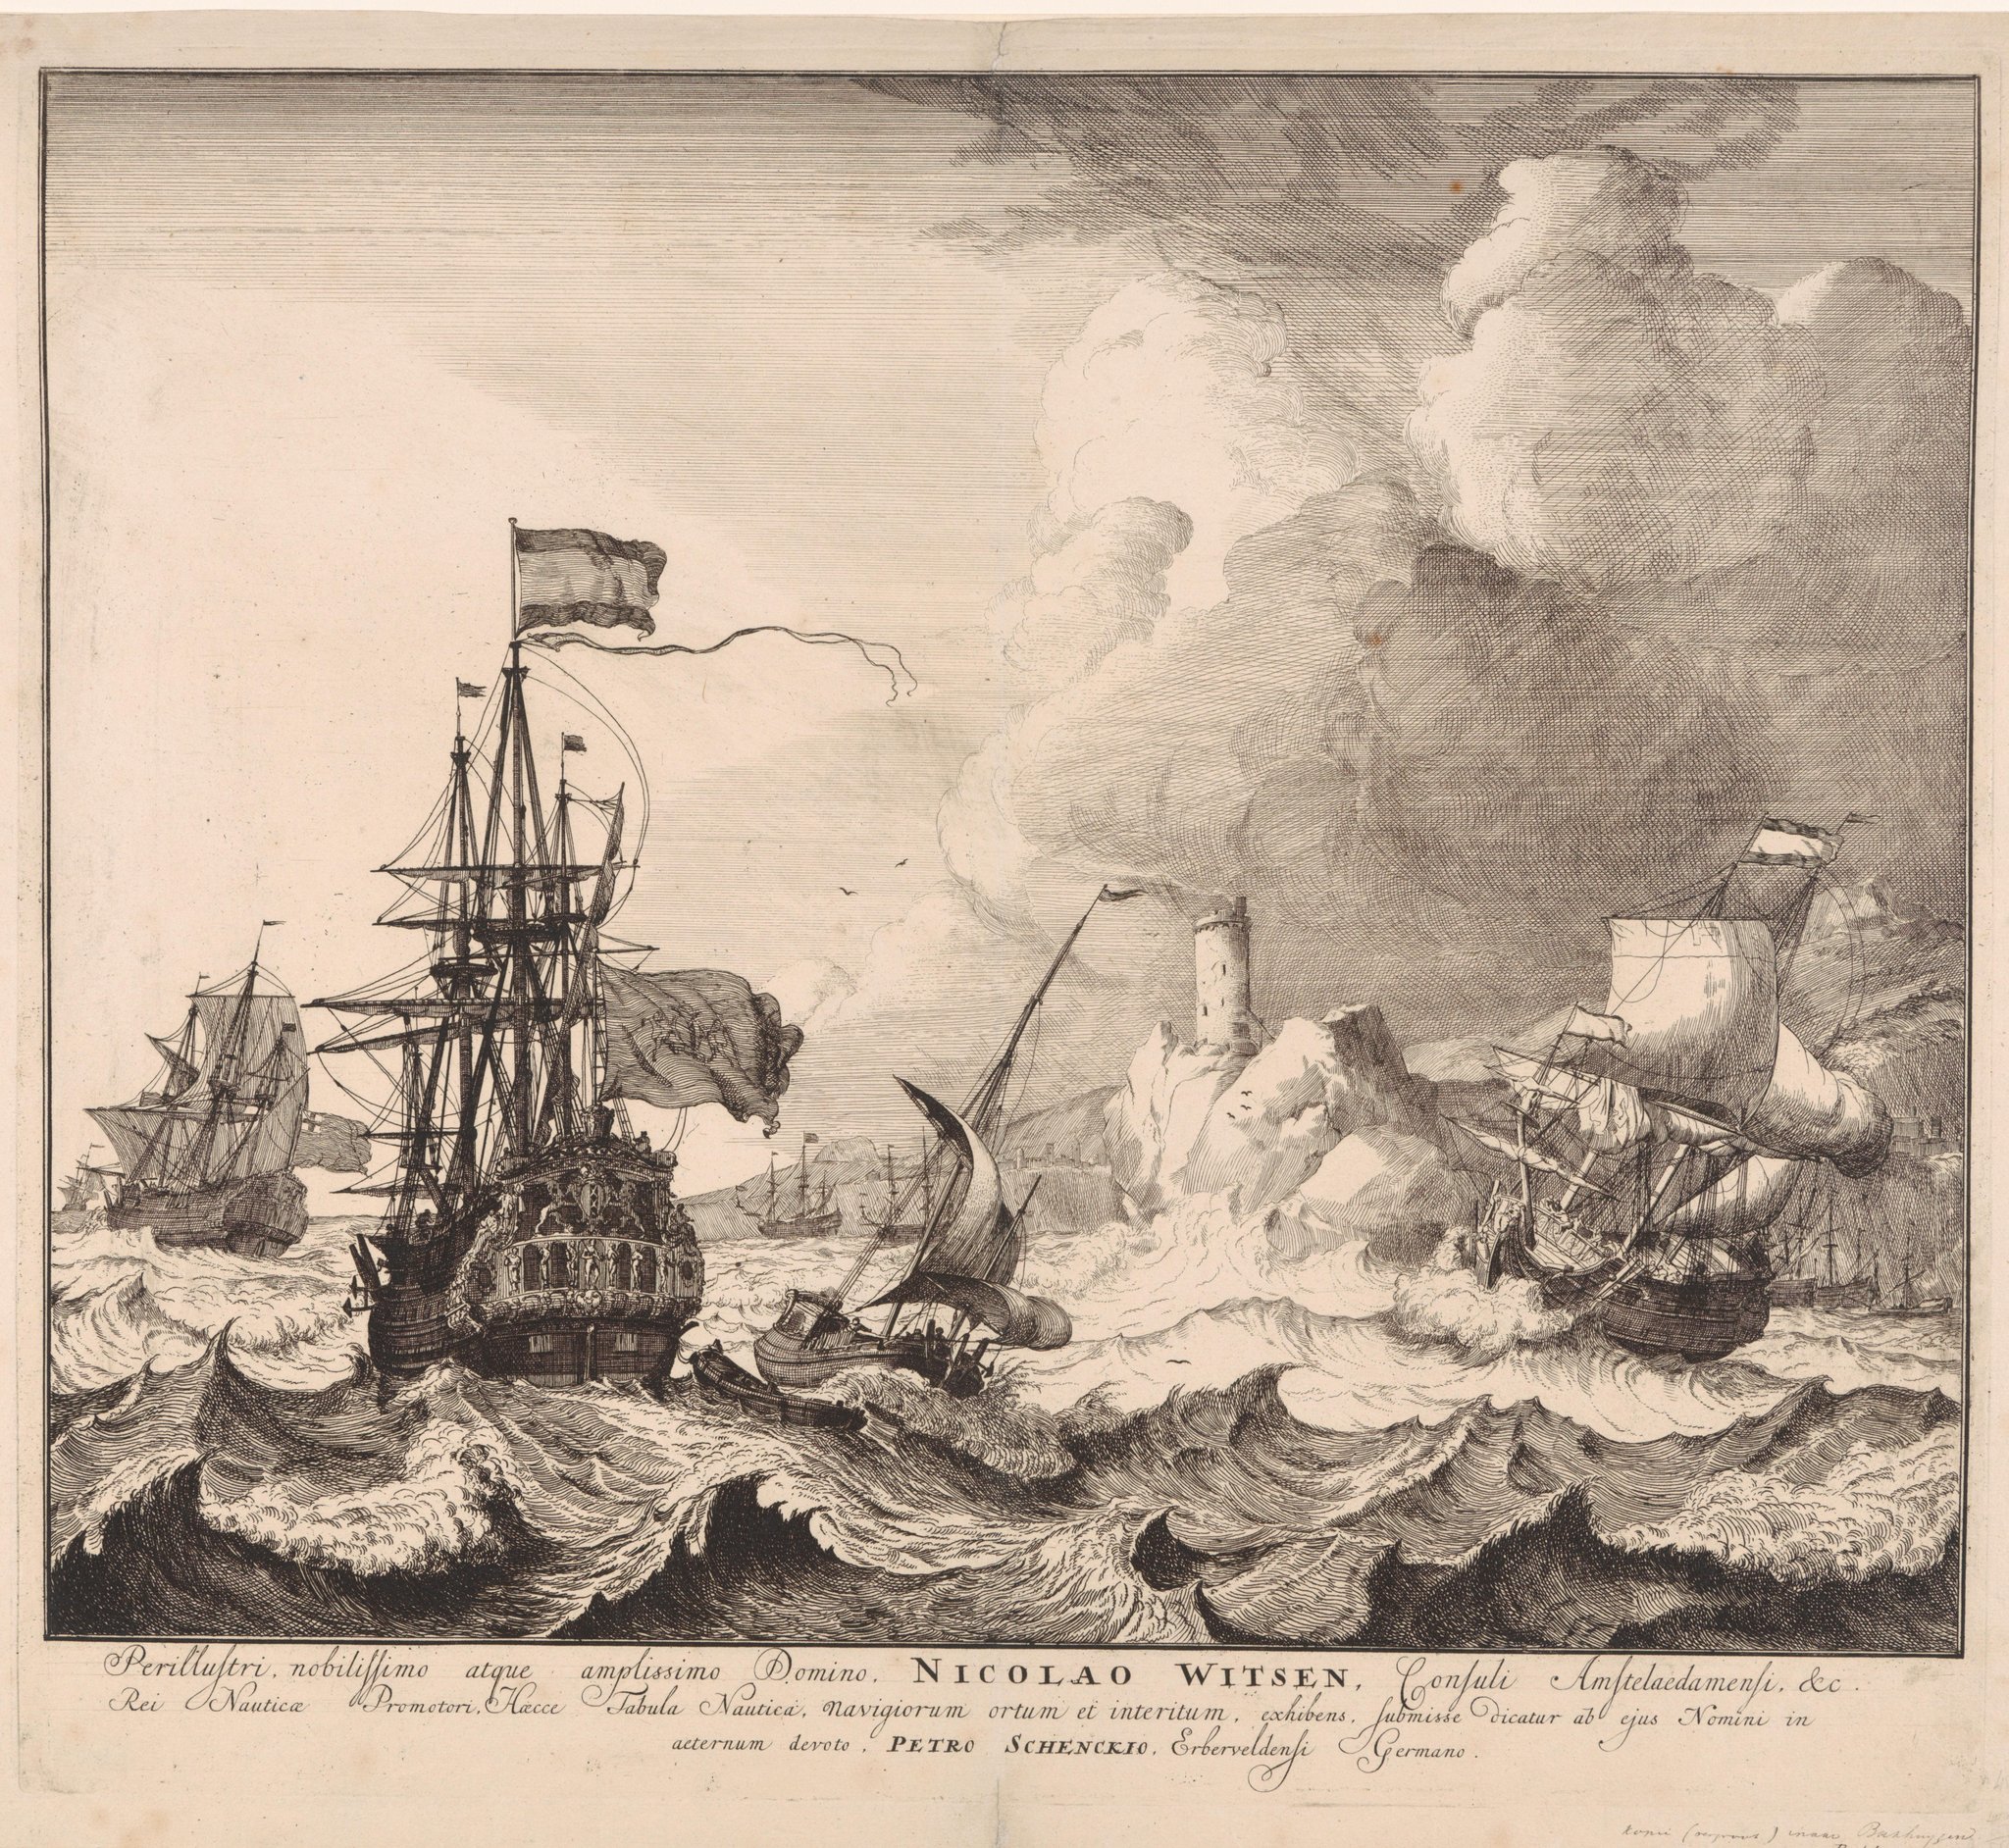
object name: print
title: Schepen bij storm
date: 1675-1711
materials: paper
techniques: etching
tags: rocky coast, ships (in general), landscape with tower or castle, storm at sea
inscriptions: collector's mark: Lugt 2228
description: Zeilschepen op een woeilige zee bij een rots waarop een toren. Rechts trekken grote wolken over het land.